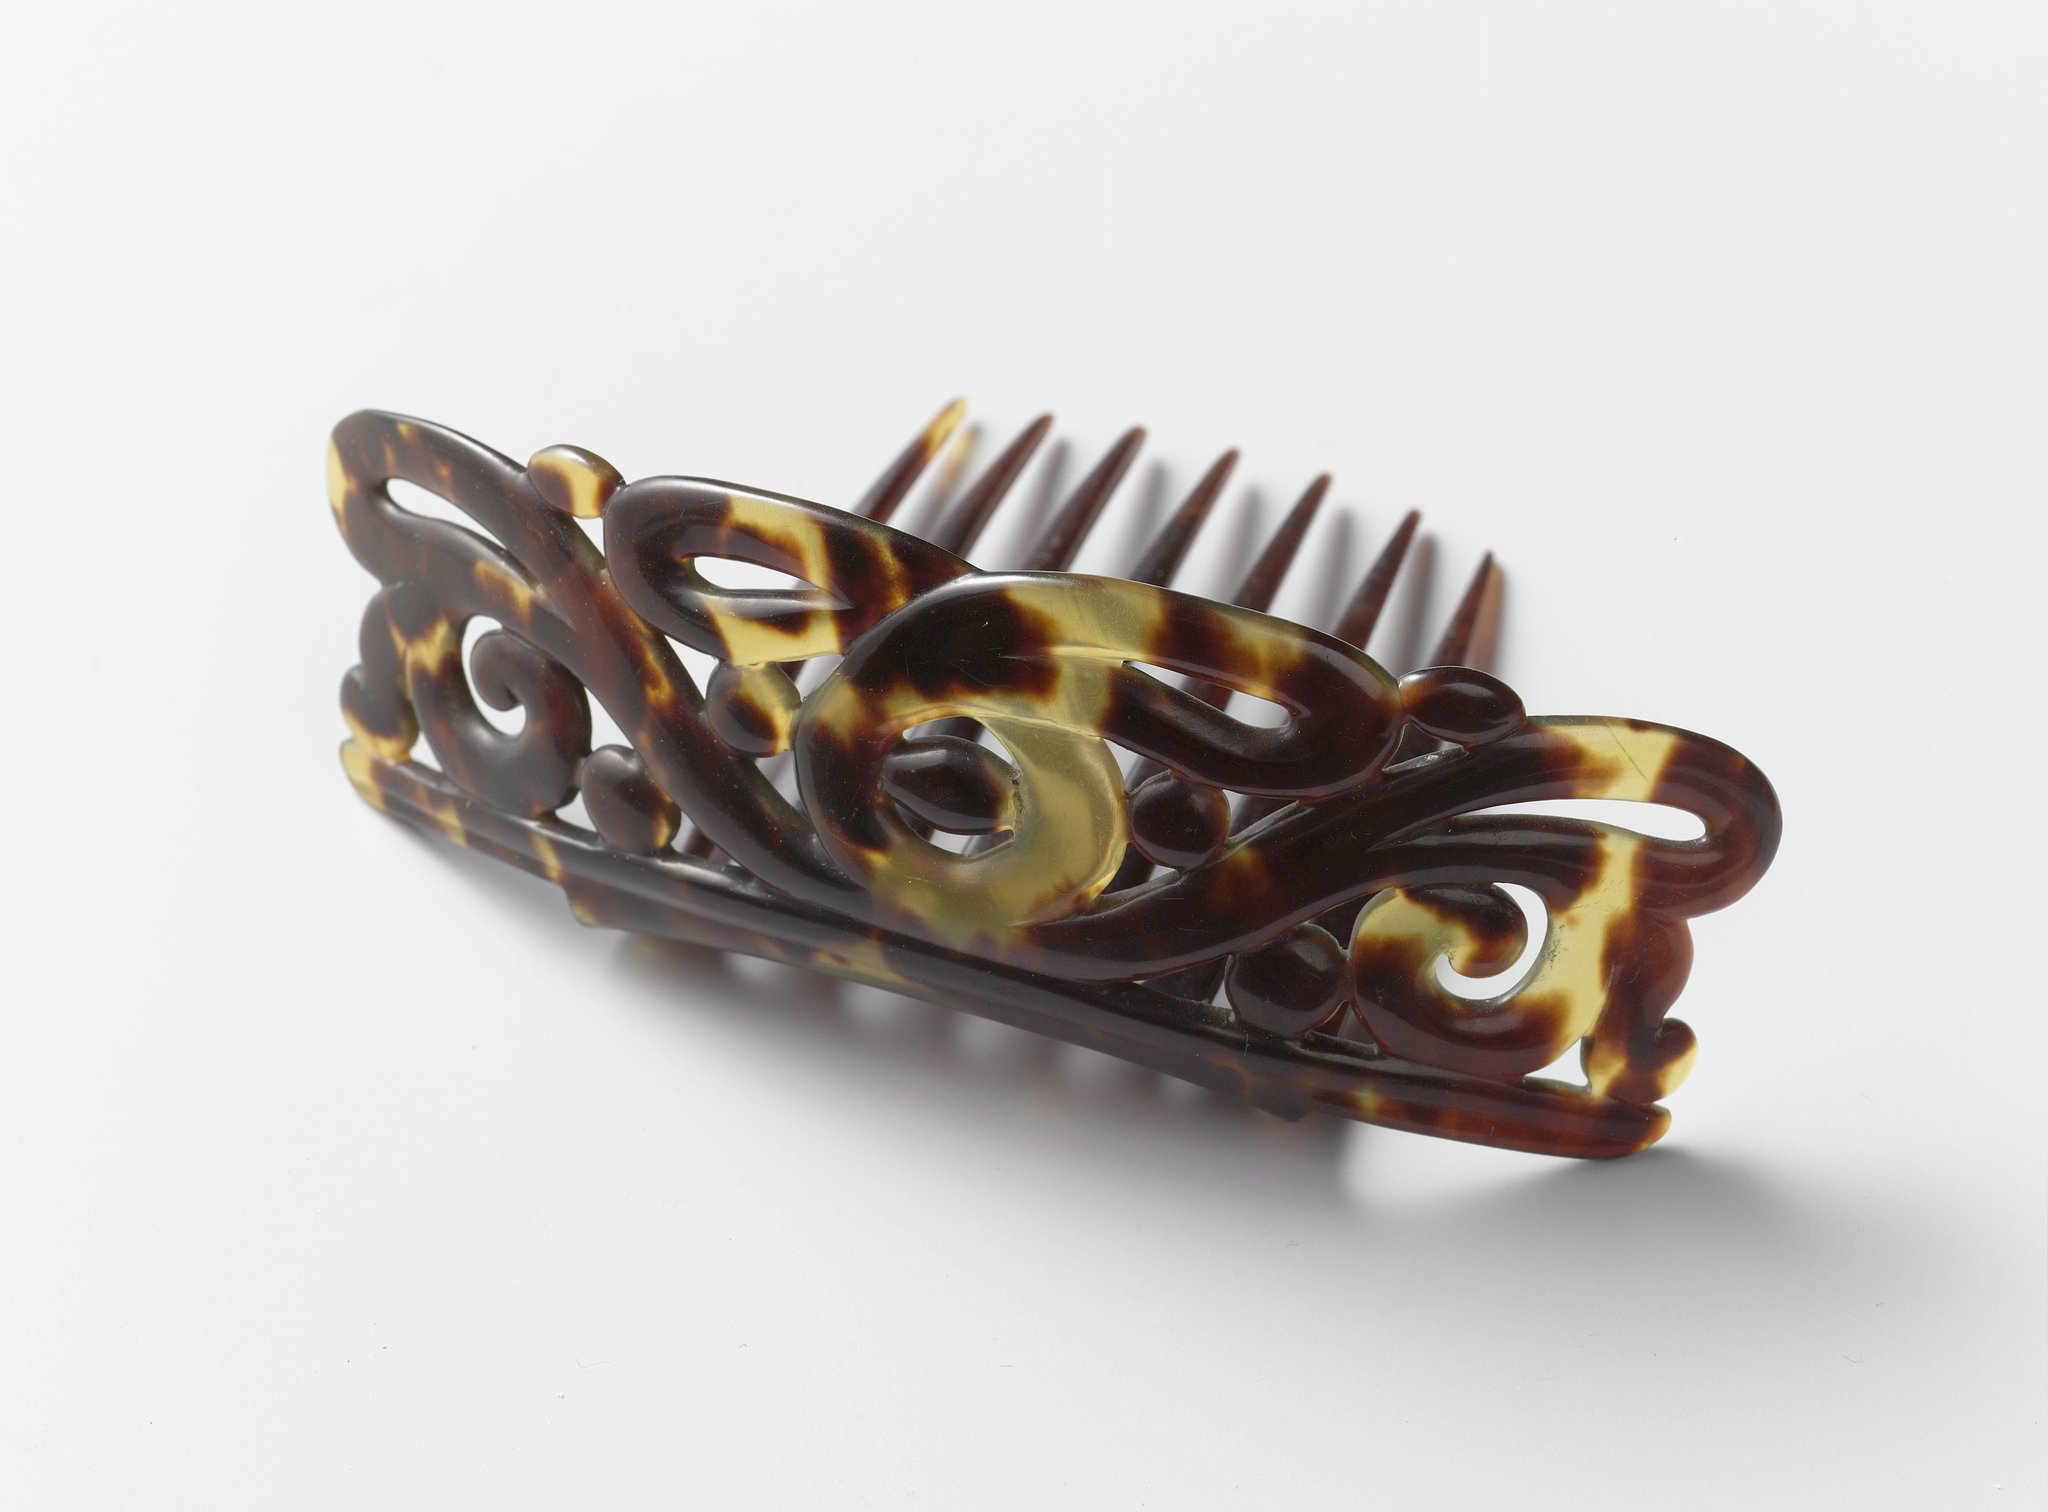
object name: comb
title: Haarkam van imitatie schildpad of hoorn met een ajour gesneden rug van sierlijk in elkaar overgaande krullen, haaks op de tanden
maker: Anonymous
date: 1850-1880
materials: celluloid, plastic, horn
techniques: cutting, embroidery, polish, pressing, sawing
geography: netherlands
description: Haarkam van imitatie schildpad of hoorn met een ajour gesneden rug van sierlijk in elkaar overgaande krullen, haaks op de tanden. Zeven tanden.